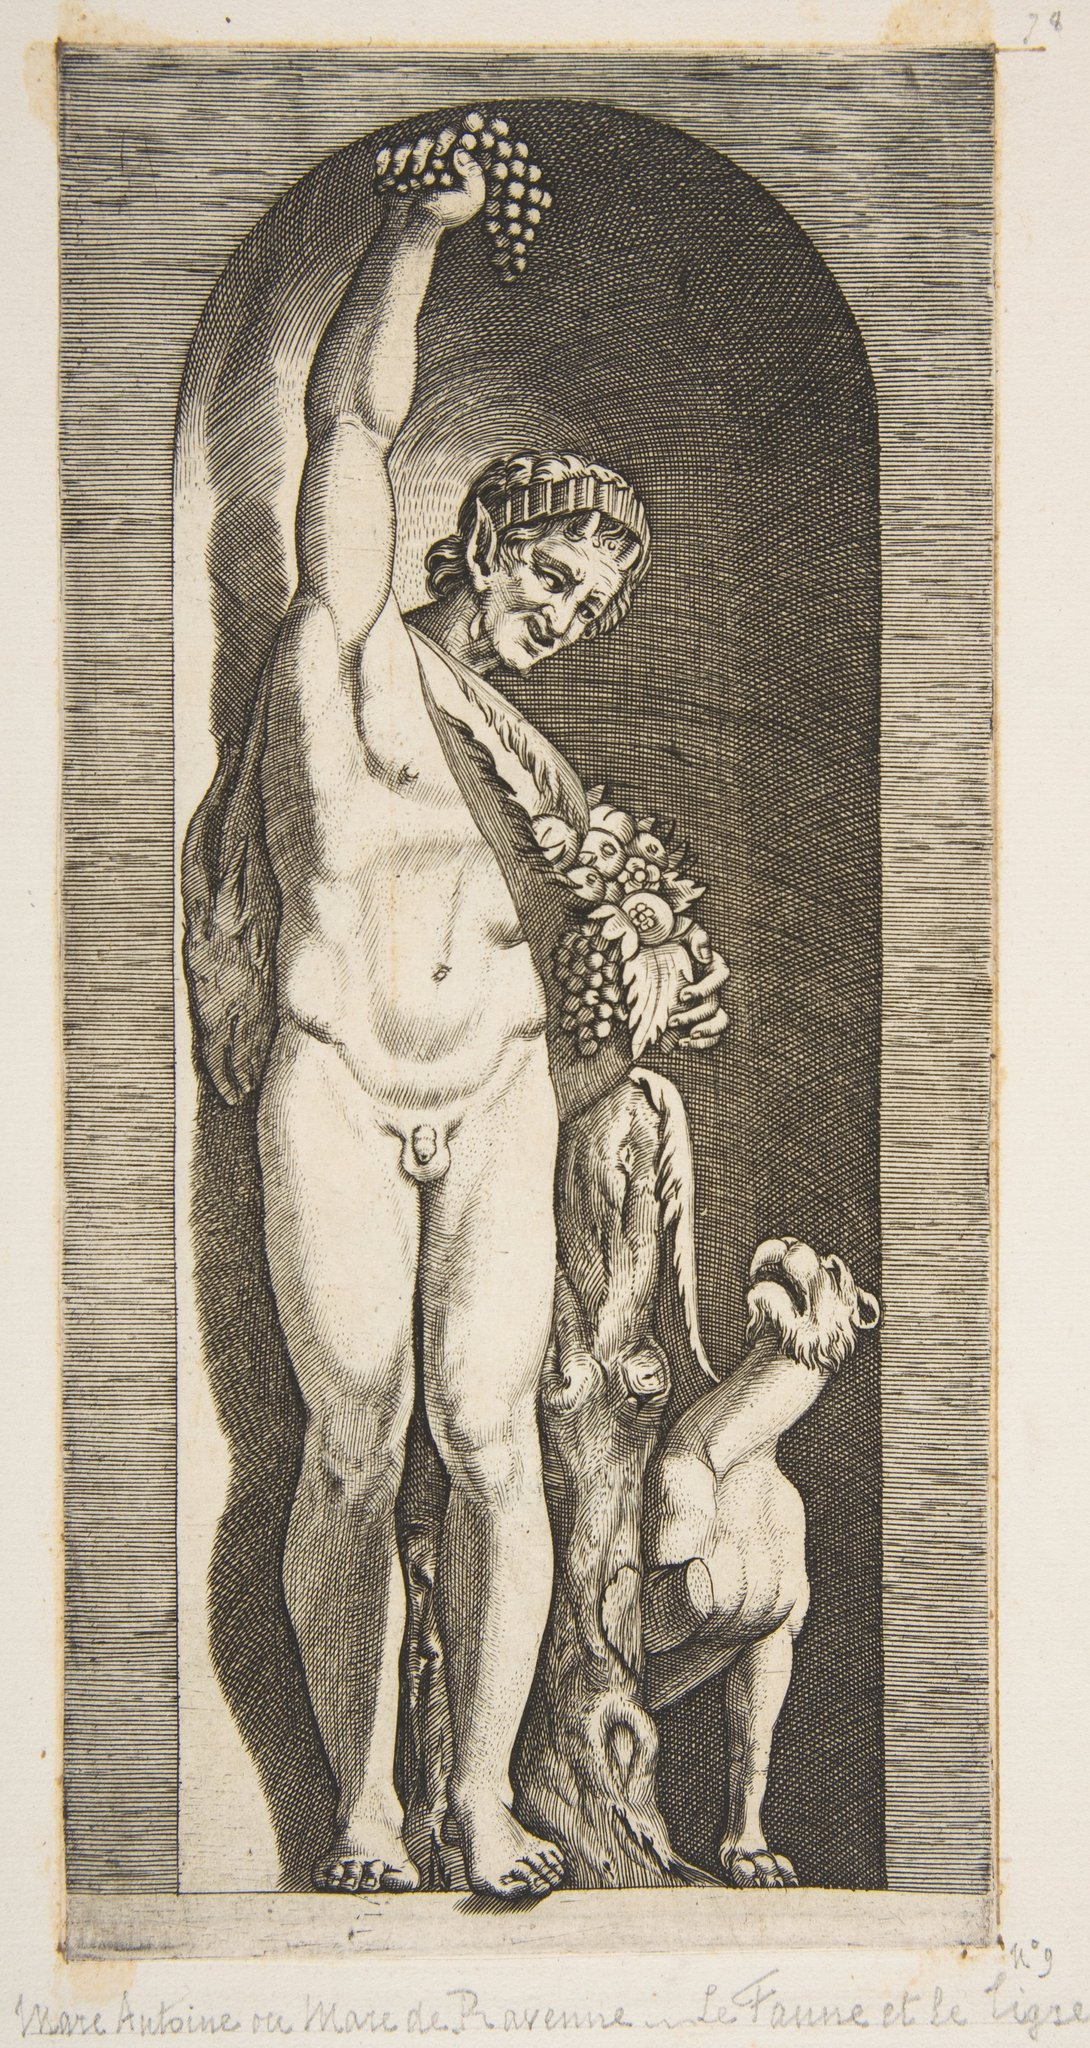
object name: print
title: A faun standing in a niche holding aloft a bunch of grapes with his right hand and fruit with his left hand, a dog lower right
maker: marco dente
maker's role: artist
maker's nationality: italian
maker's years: 1515-1527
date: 1515-1527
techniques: engraving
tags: fruit,grapes,fauns,dogs